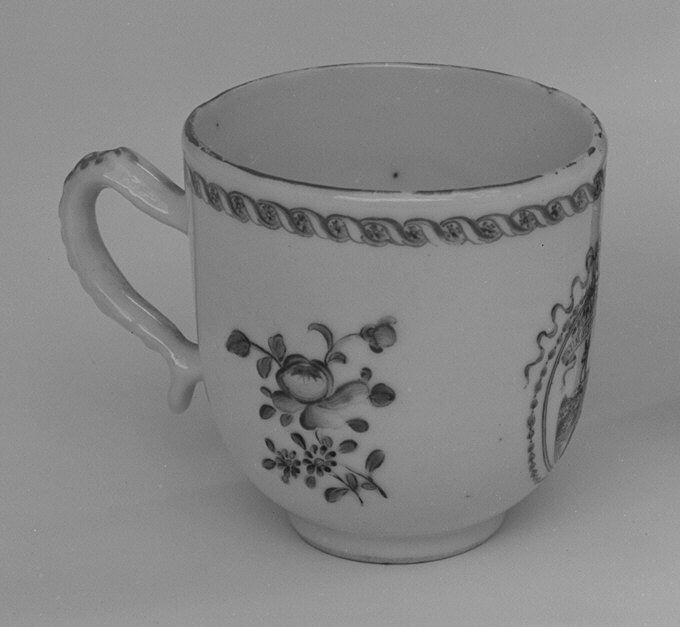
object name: cup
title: Cup (part of a service)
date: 1770-1785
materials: hard paste porcelain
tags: flowers